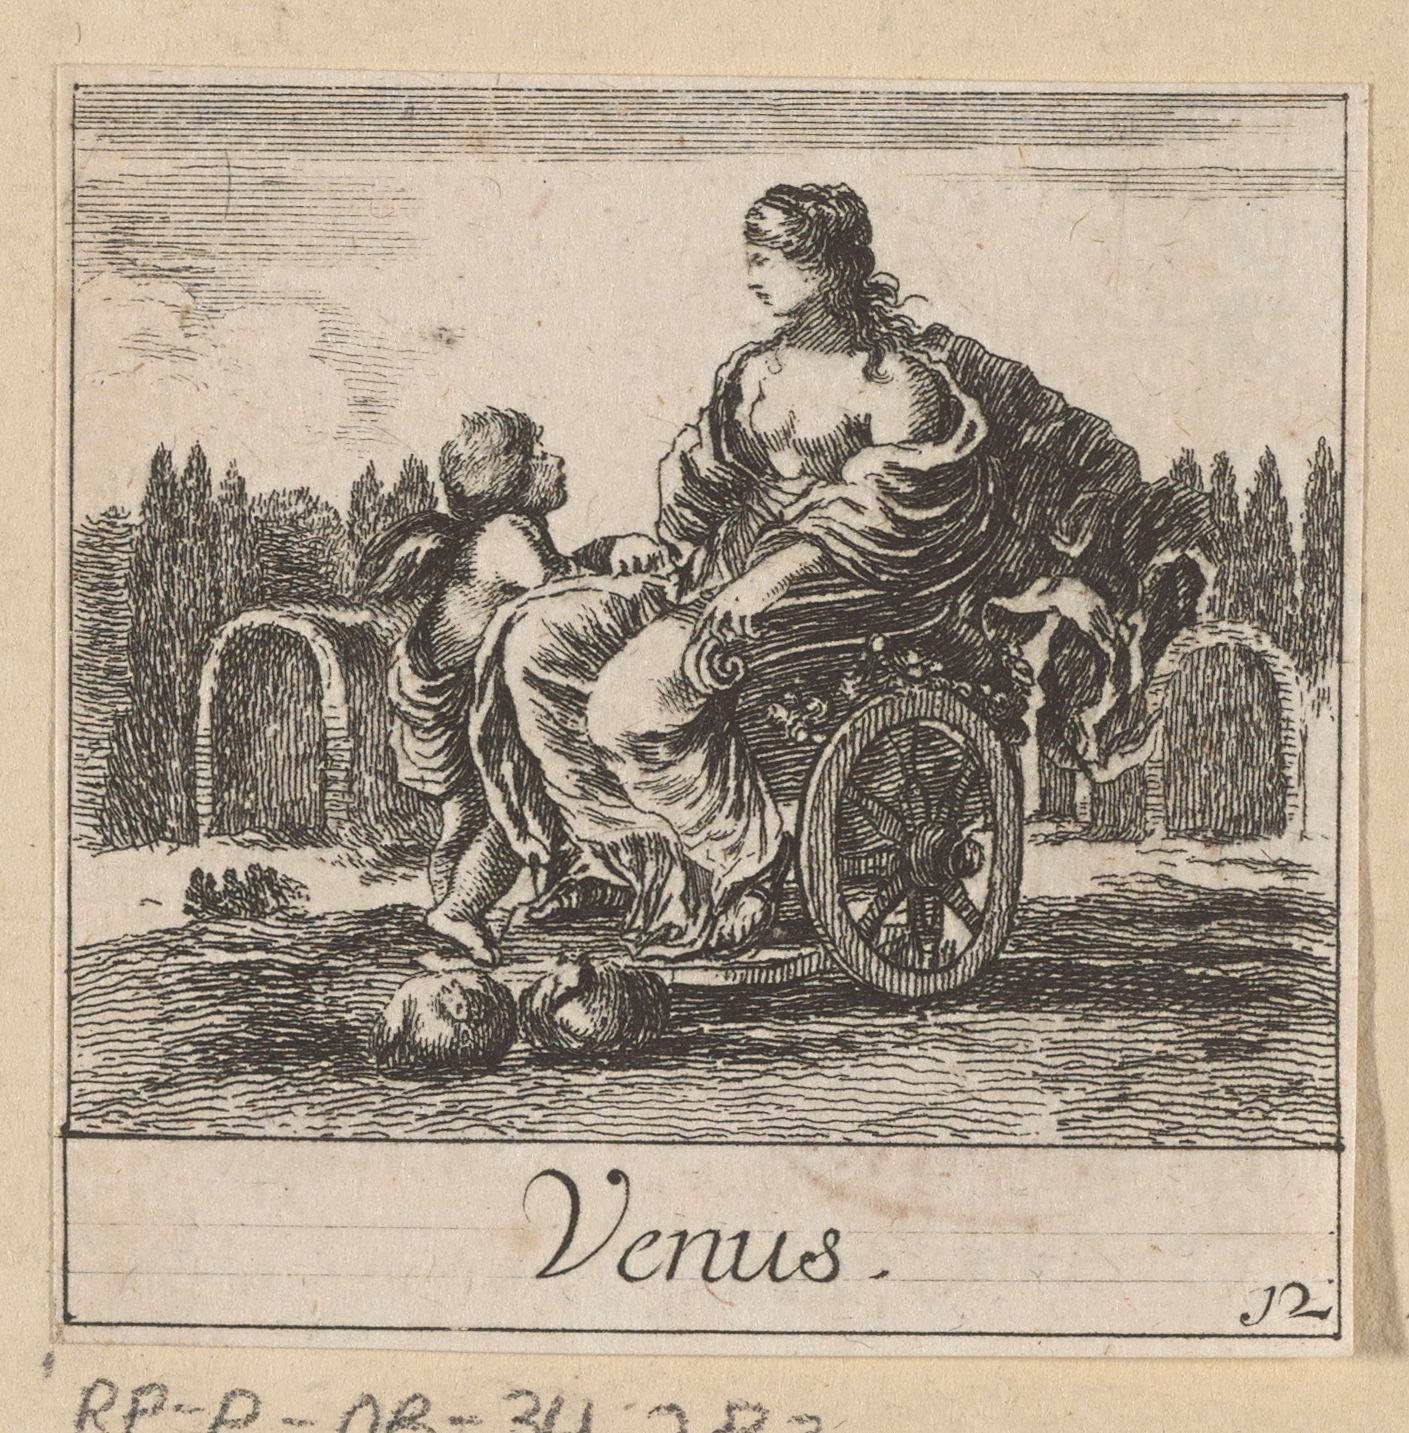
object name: print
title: Jeu des fables (kopie)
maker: Anonymous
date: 1620-1664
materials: paper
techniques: etching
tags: venus and cupid (cupid not being mere attribute)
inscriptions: collector's mark: Lugt 240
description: Prent uit een reeks van 54 genummerde speelkaarten met voorstellingen uit de Metamorfosen van Ovidius.